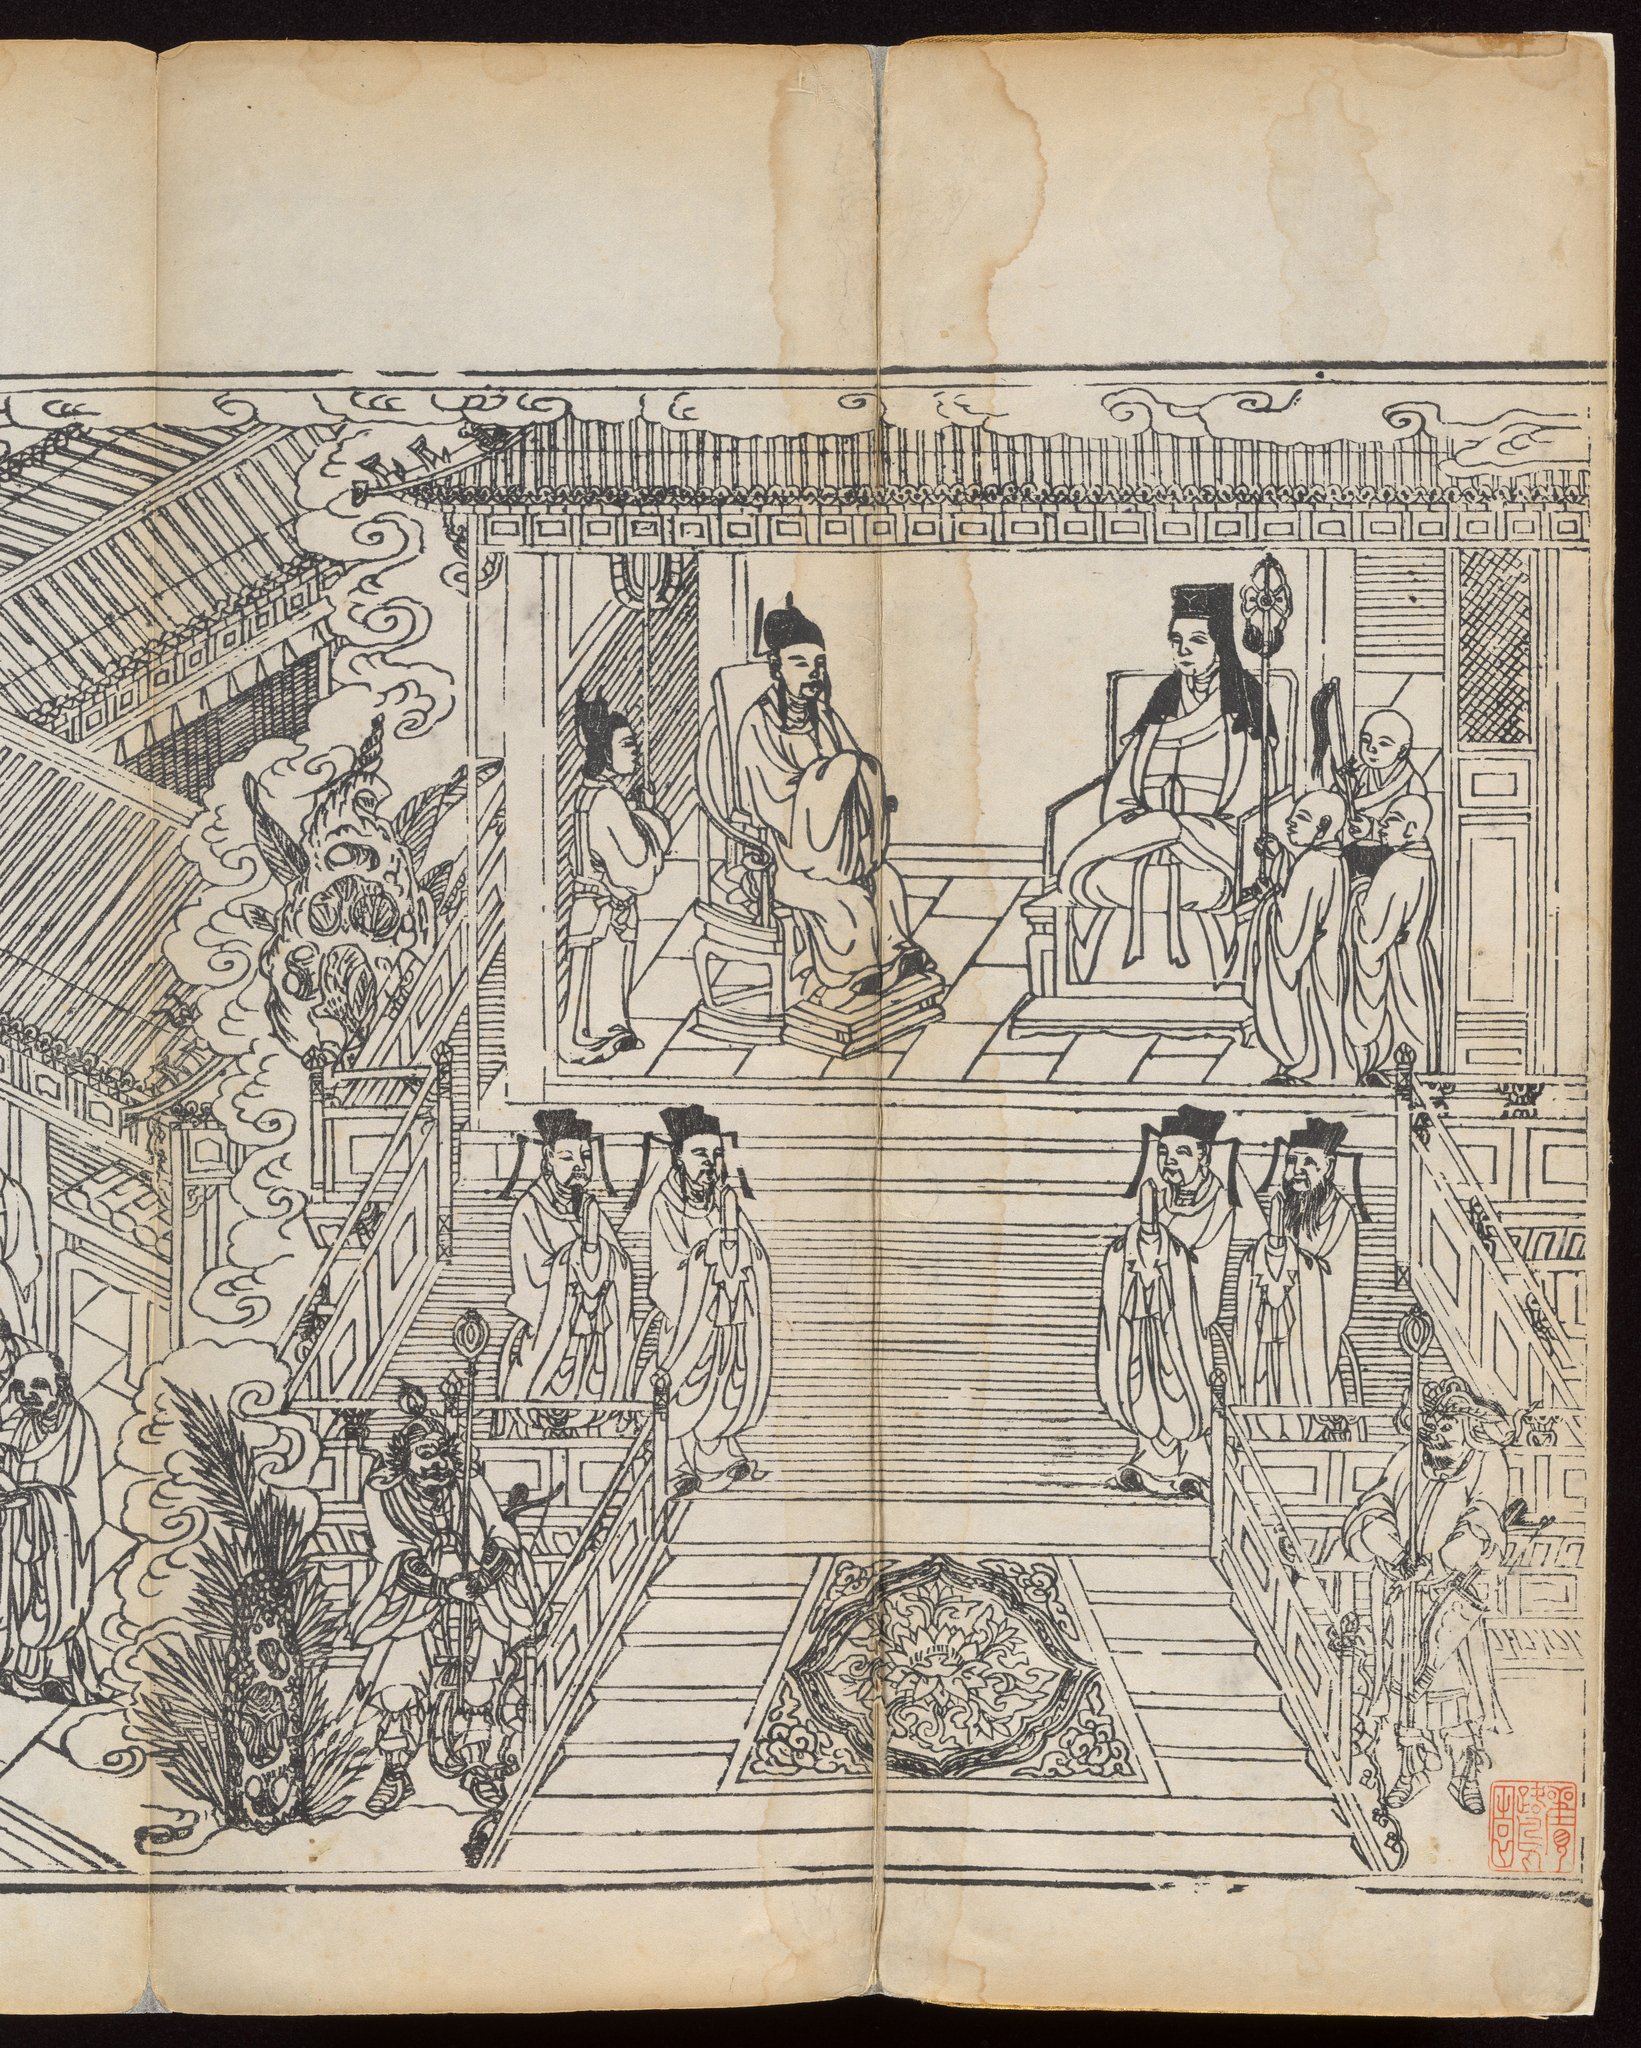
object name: illustrated book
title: Sutra of the Repentance Ritual of Great Compassion (Cibei daochang chanfa), Volume 1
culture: chinese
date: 1615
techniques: woodblock print